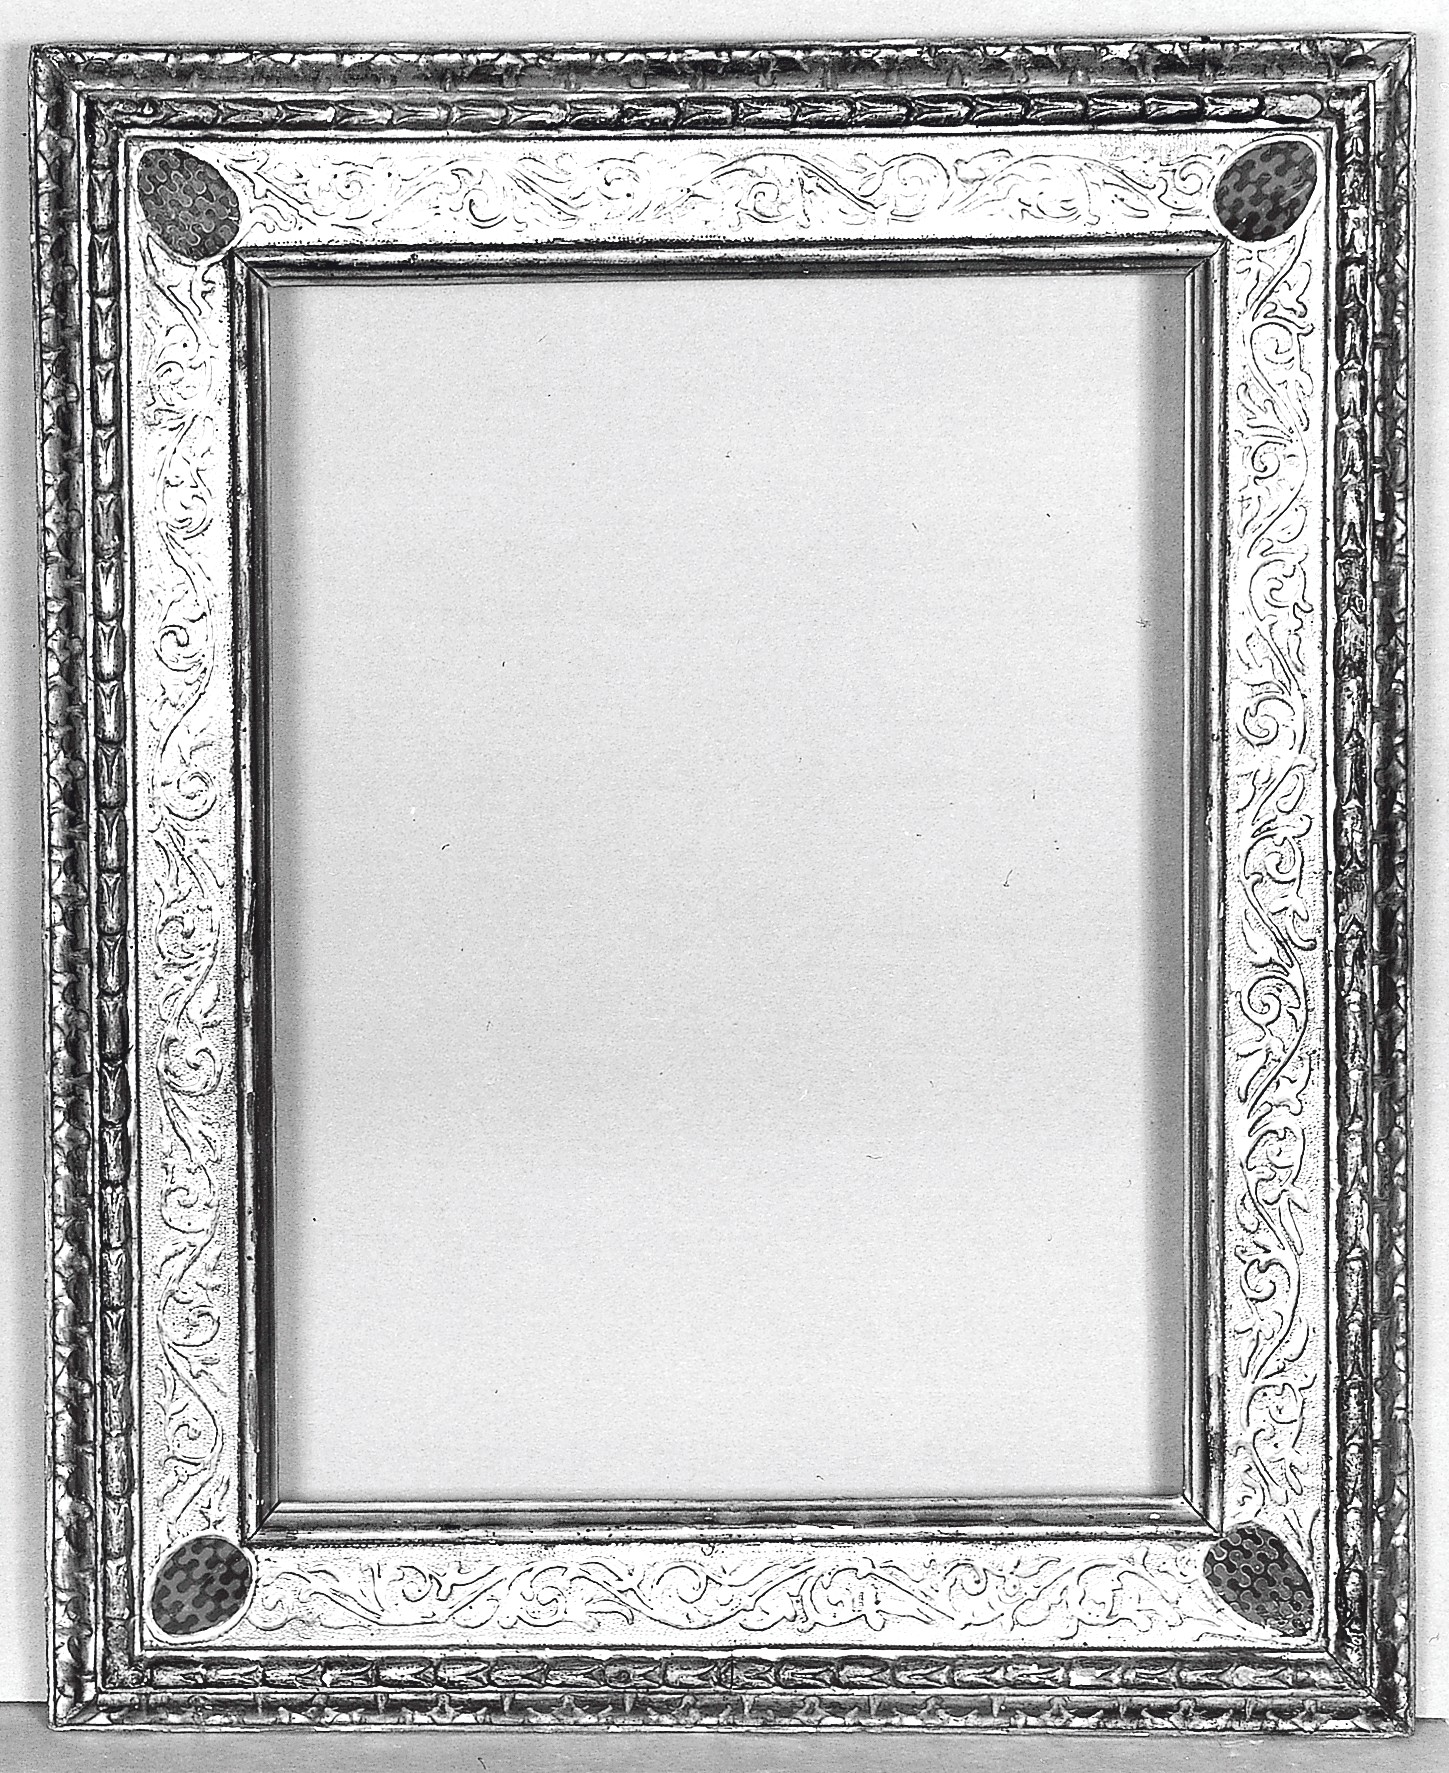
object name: frame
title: Cassetta frame (pair with 1975.1.95b)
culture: italian, lombardy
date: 1601-1633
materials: wood